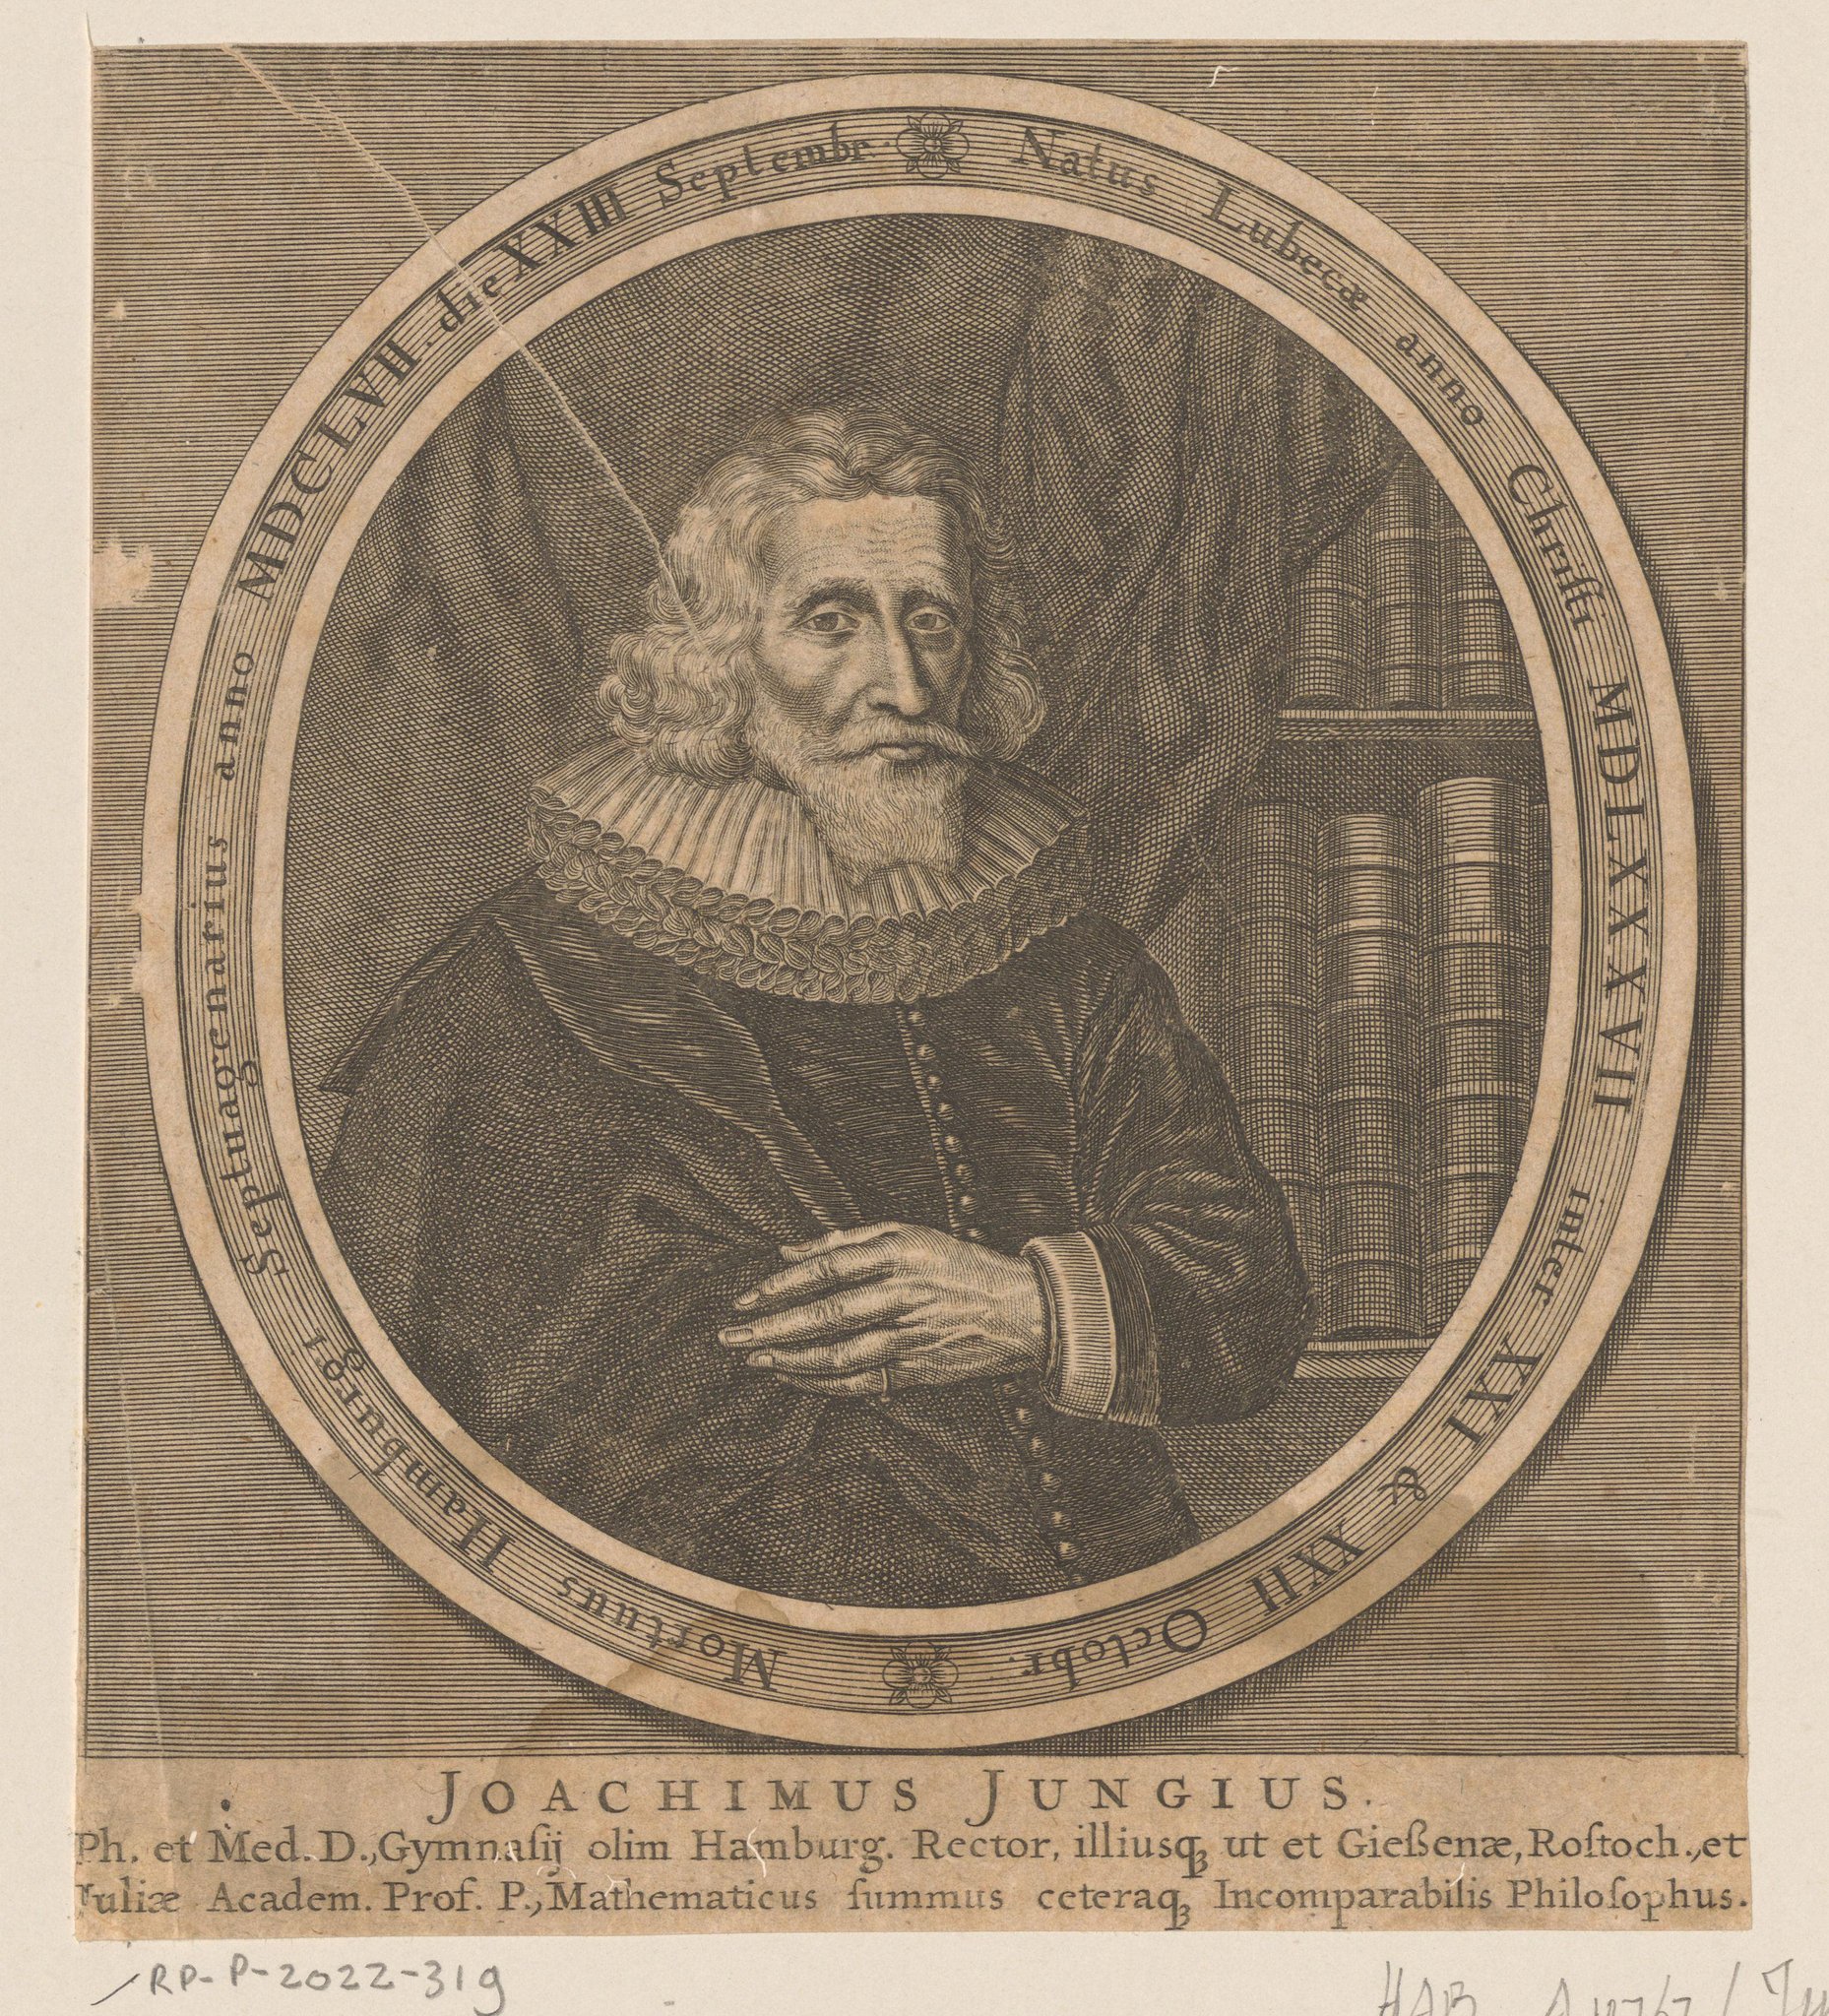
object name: print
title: Portret van Joachim Jungius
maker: Anonymous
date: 1679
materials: paper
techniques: engraving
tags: scholar, philosopher, historical persons, mathematics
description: Prent waarschijnlijk uit: Jungius, Joachim. Præcipuæ opiniones physicæ passim receptæ, breviter quidem sed (...). Hamburg: Johann Naumann, 1679.